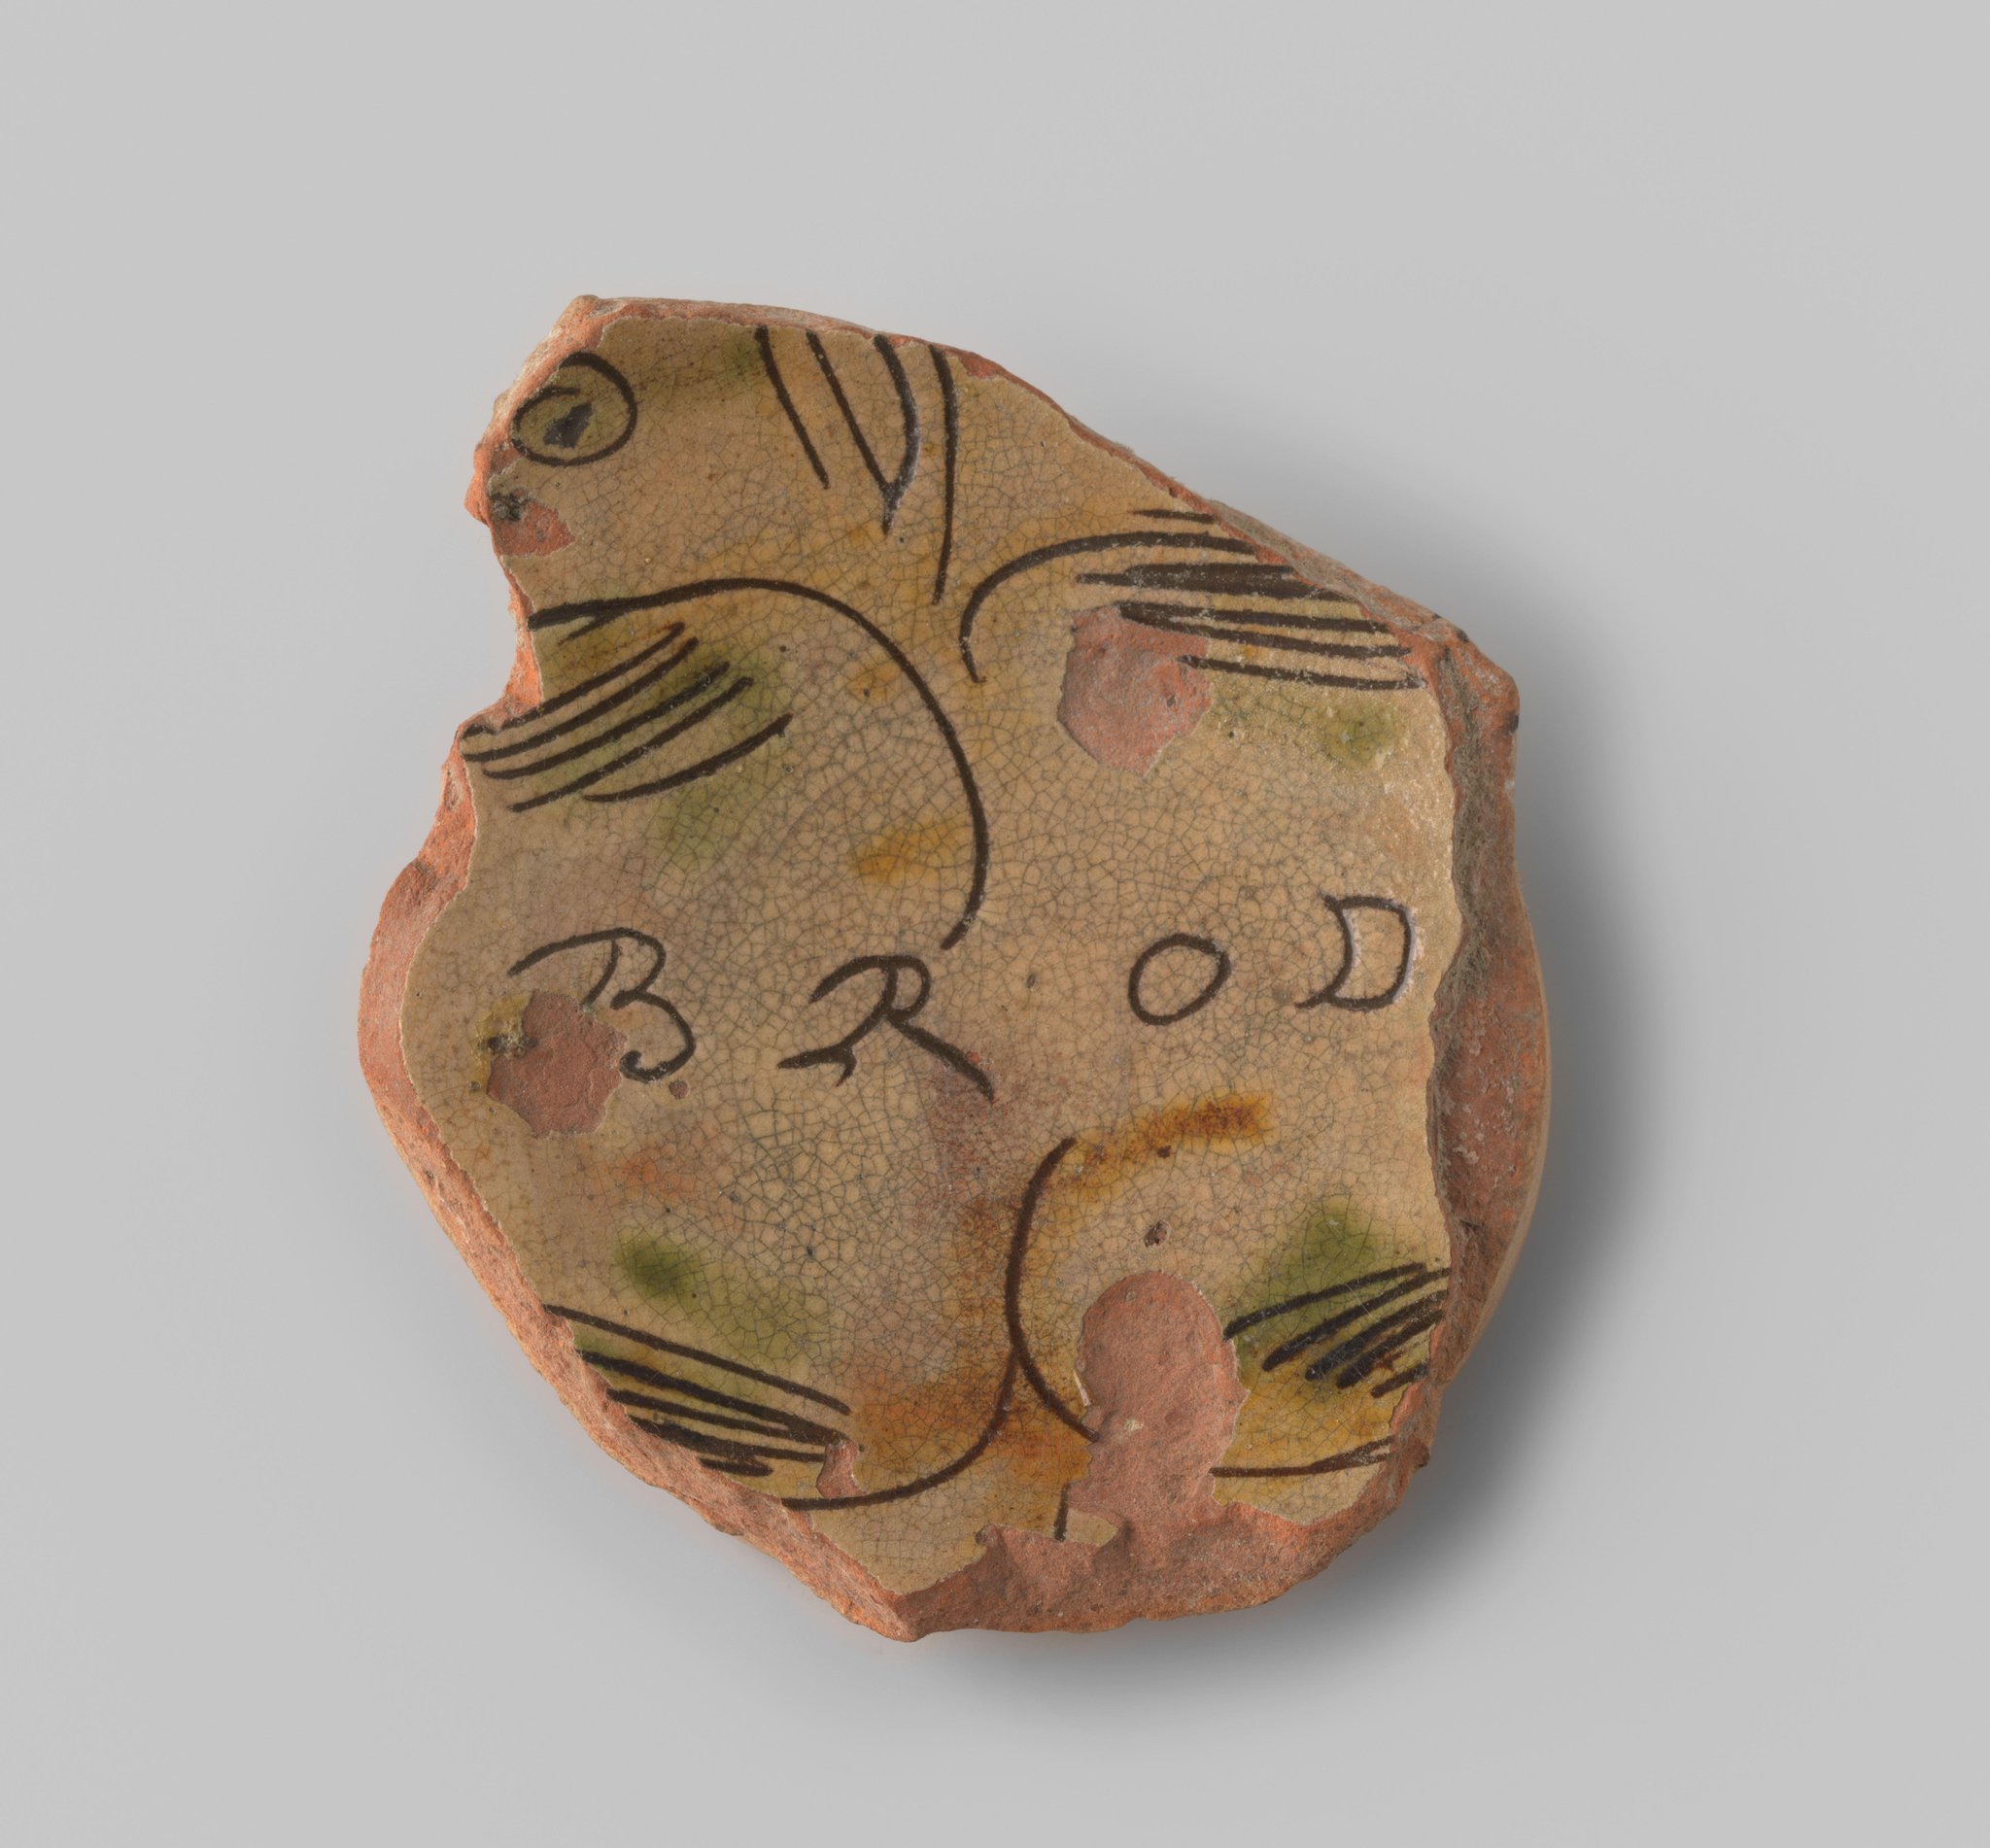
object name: sherd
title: Fragment (voet) met rode scherf, in sgraffito-techniek enkele bladeren(?), waartussen de letters BROD, op een beige fond met hier en daar oker en groen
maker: Anonymous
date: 1200-1899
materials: earthenware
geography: italy